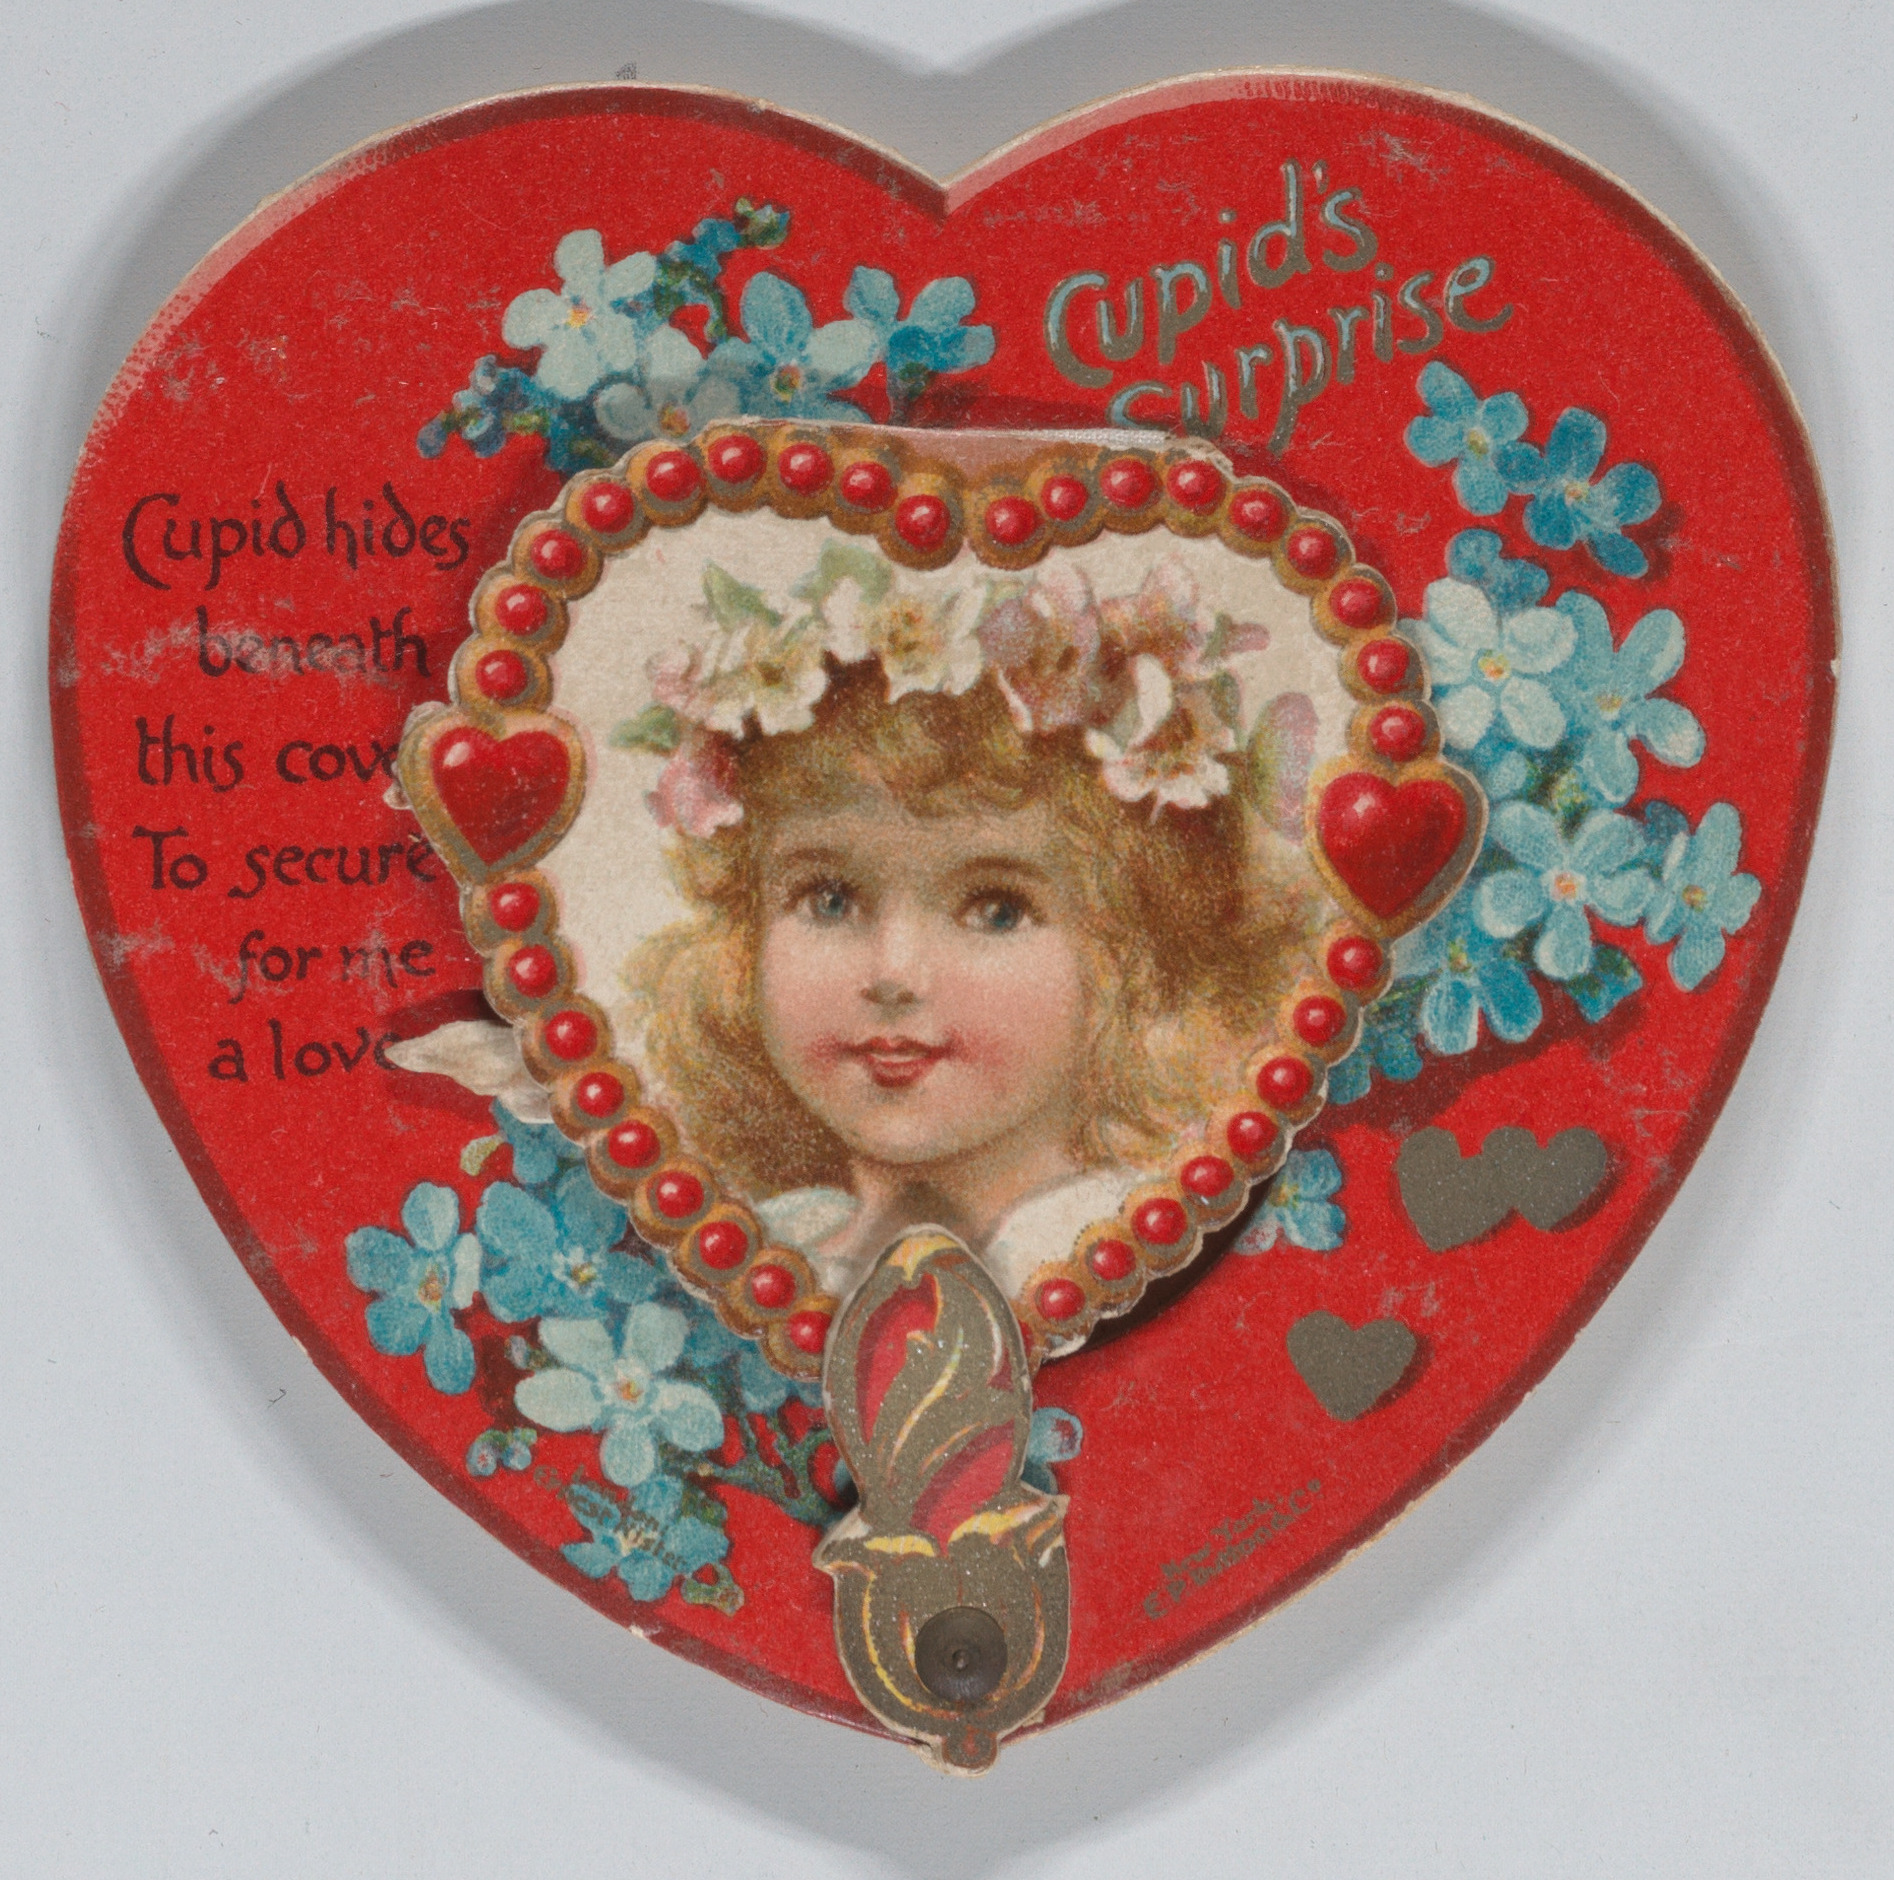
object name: valentine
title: Valentine - Mechanical - Heart opens to reveal Cupid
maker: anonymous, british or american, 19th century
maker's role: artist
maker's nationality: british or american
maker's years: 1800-1900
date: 1875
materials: brass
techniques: chromolithography, cutting